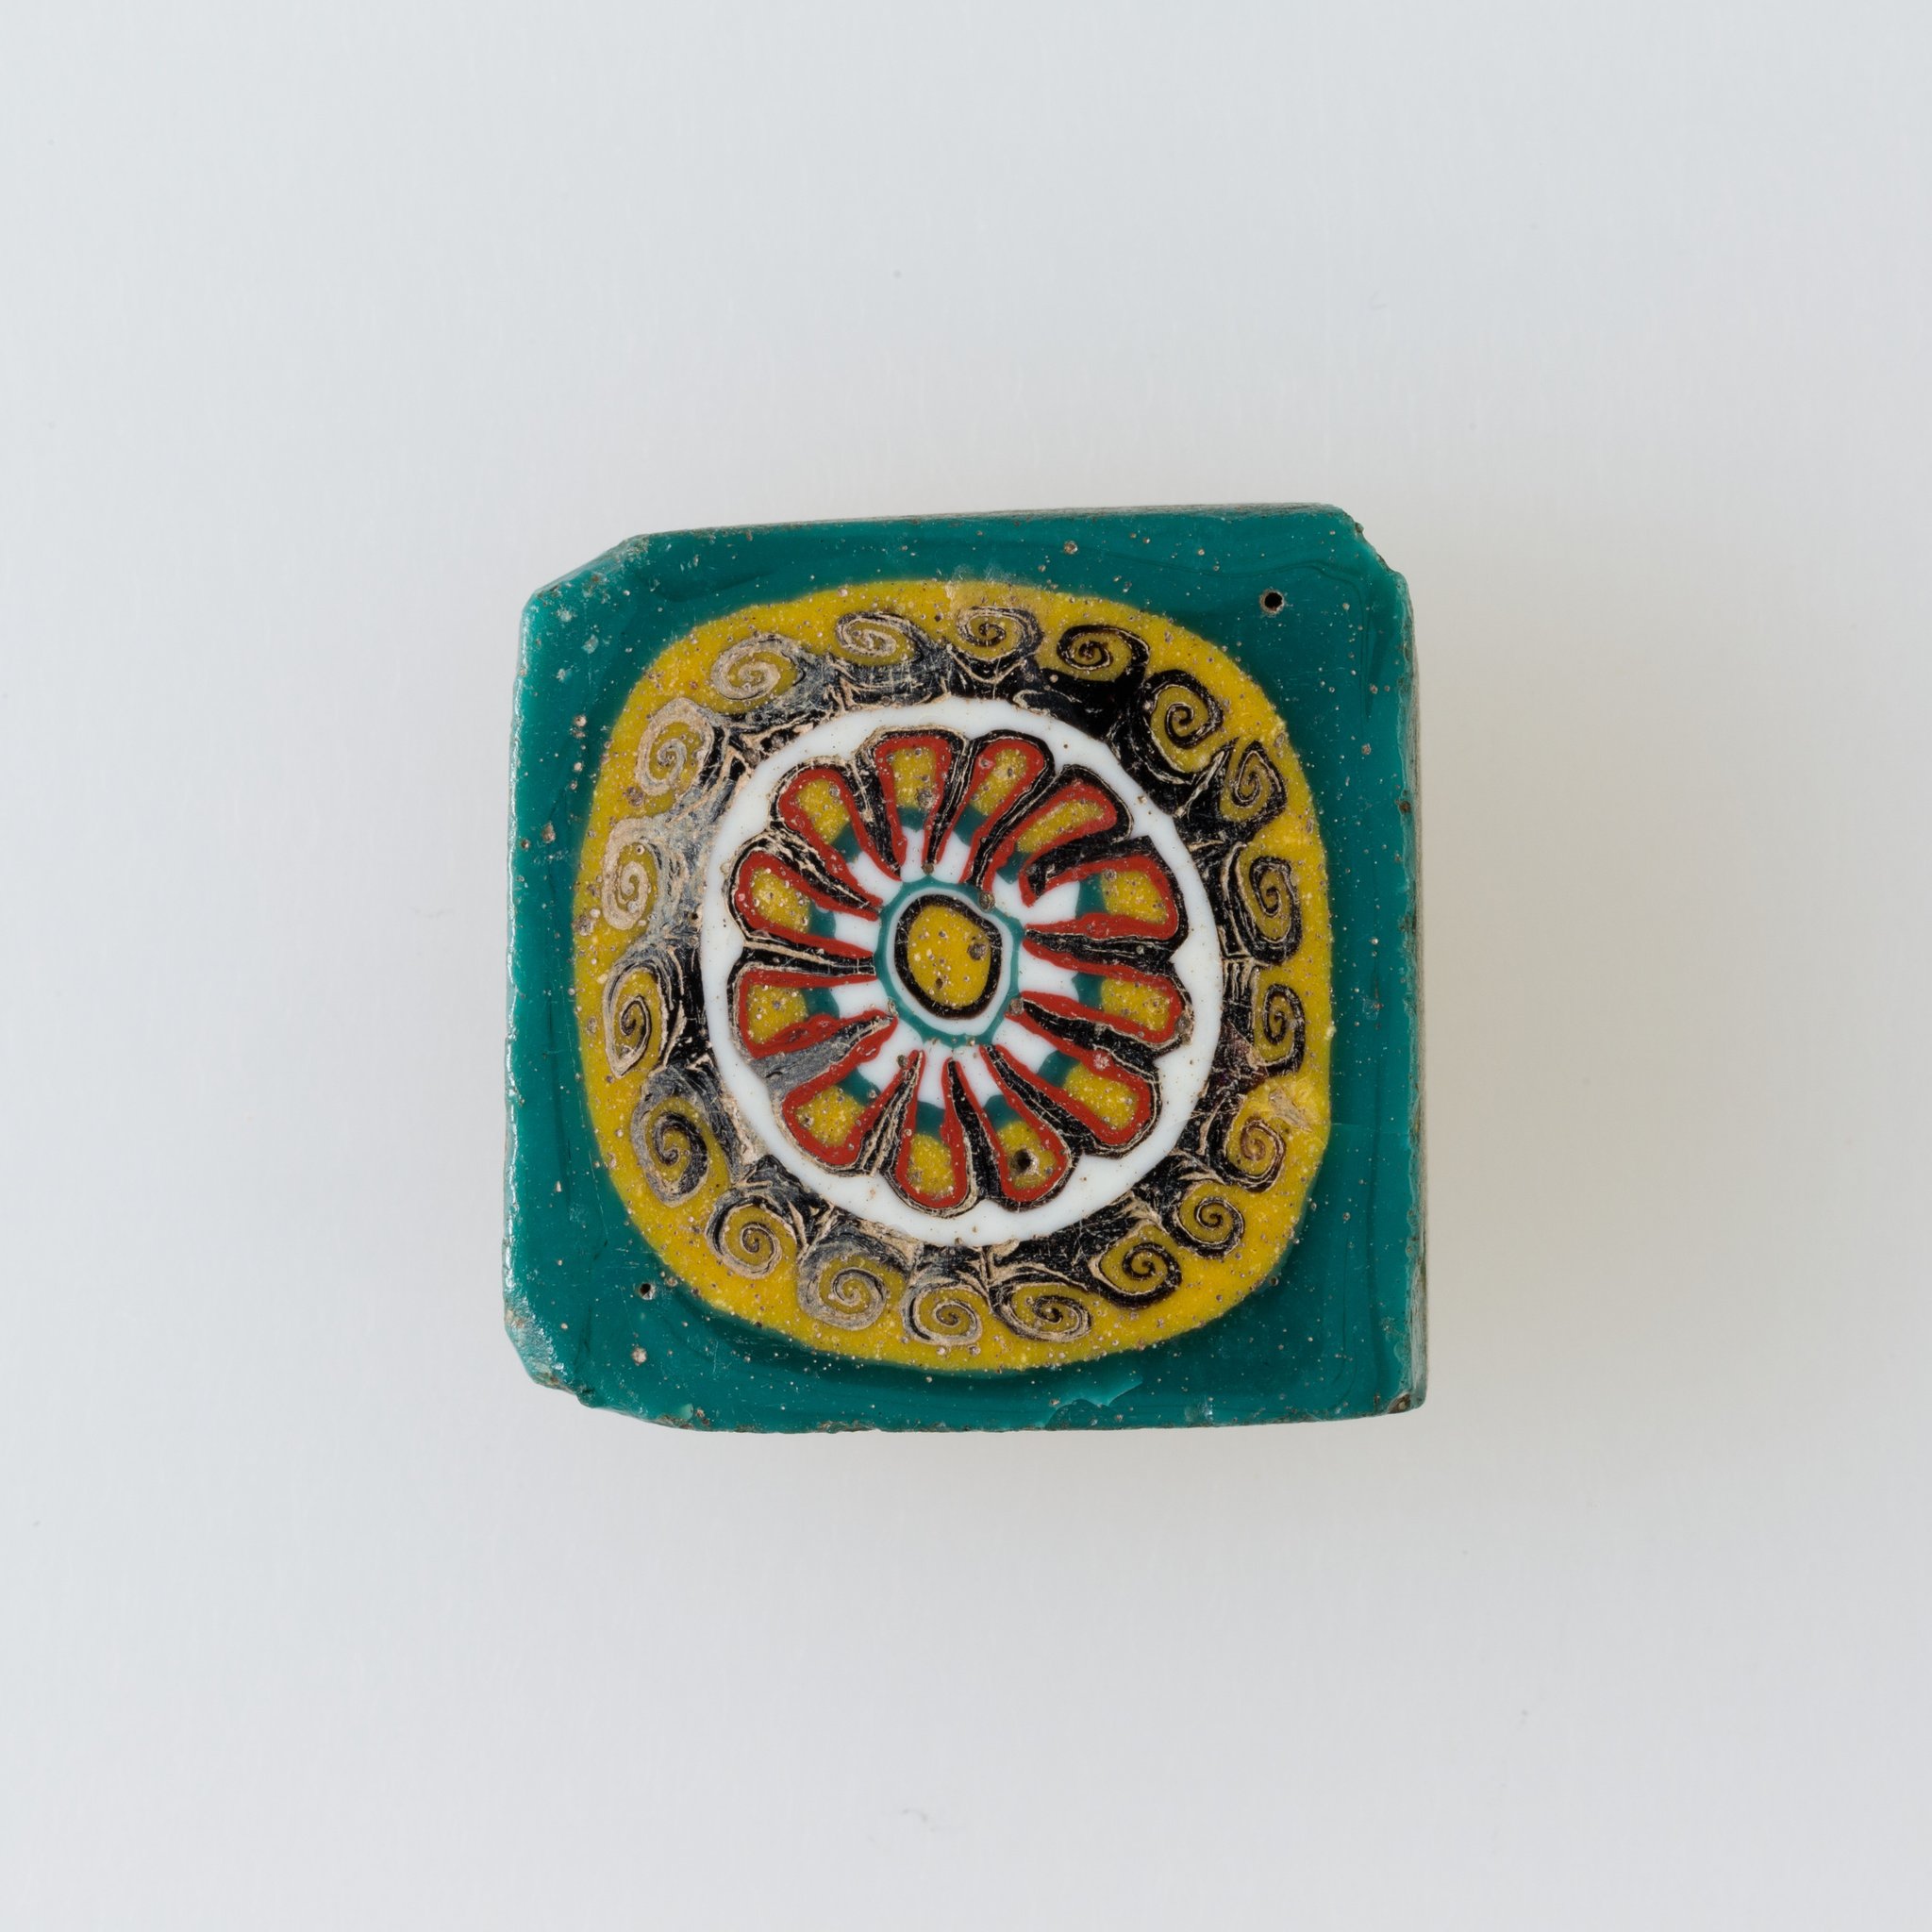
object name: inlay, rosette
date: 100 BCE-100 CE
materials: glass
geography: egypt